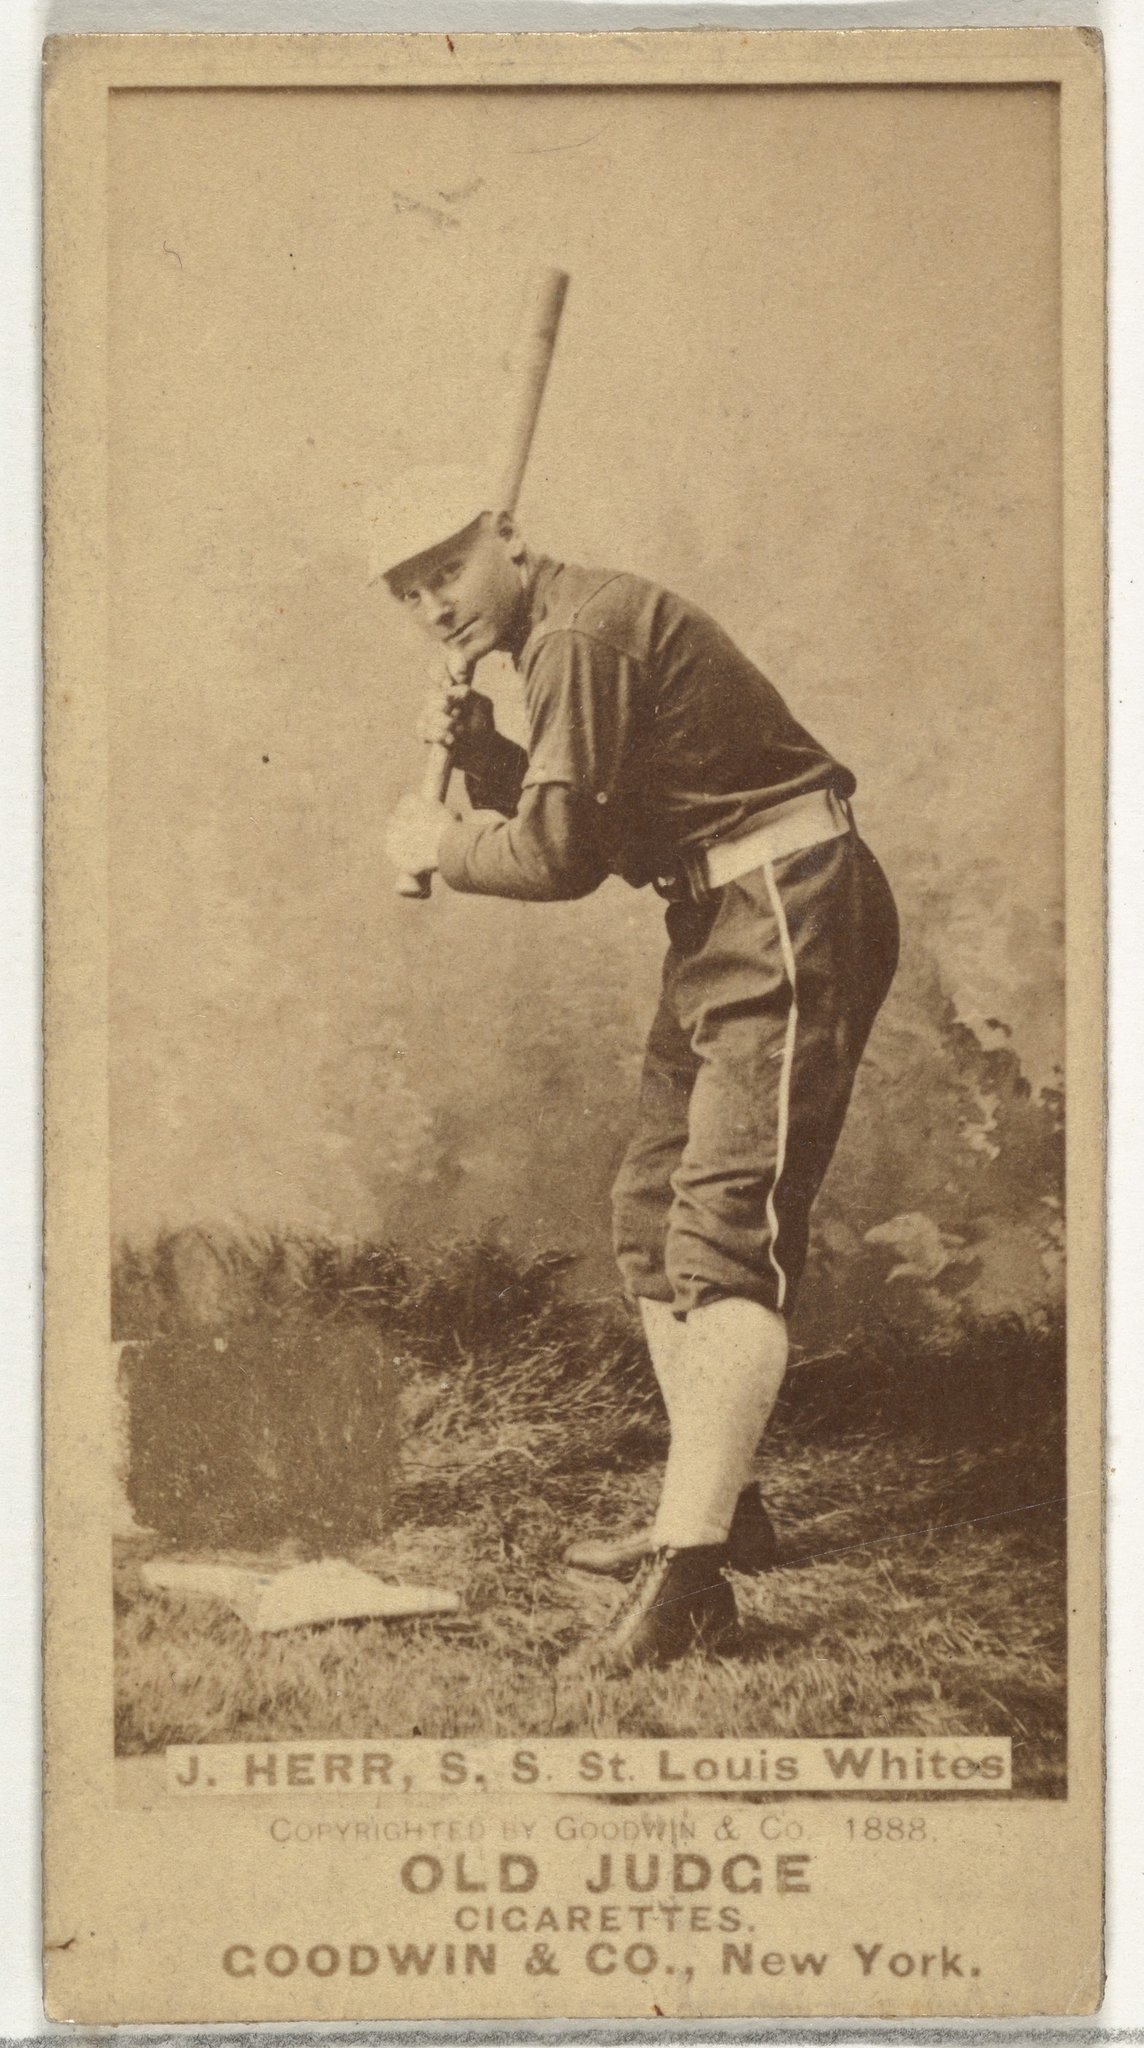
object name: baseball card, photograph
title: Herr, Shortstop, St. Louis Whites, from the Old Judge series (N172) for Old Judge Cigarettes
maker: goodwin & company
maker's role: publisher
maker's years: 1850-1950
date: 1888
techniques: albumen silver print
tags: men,portraits,baseball,athletes